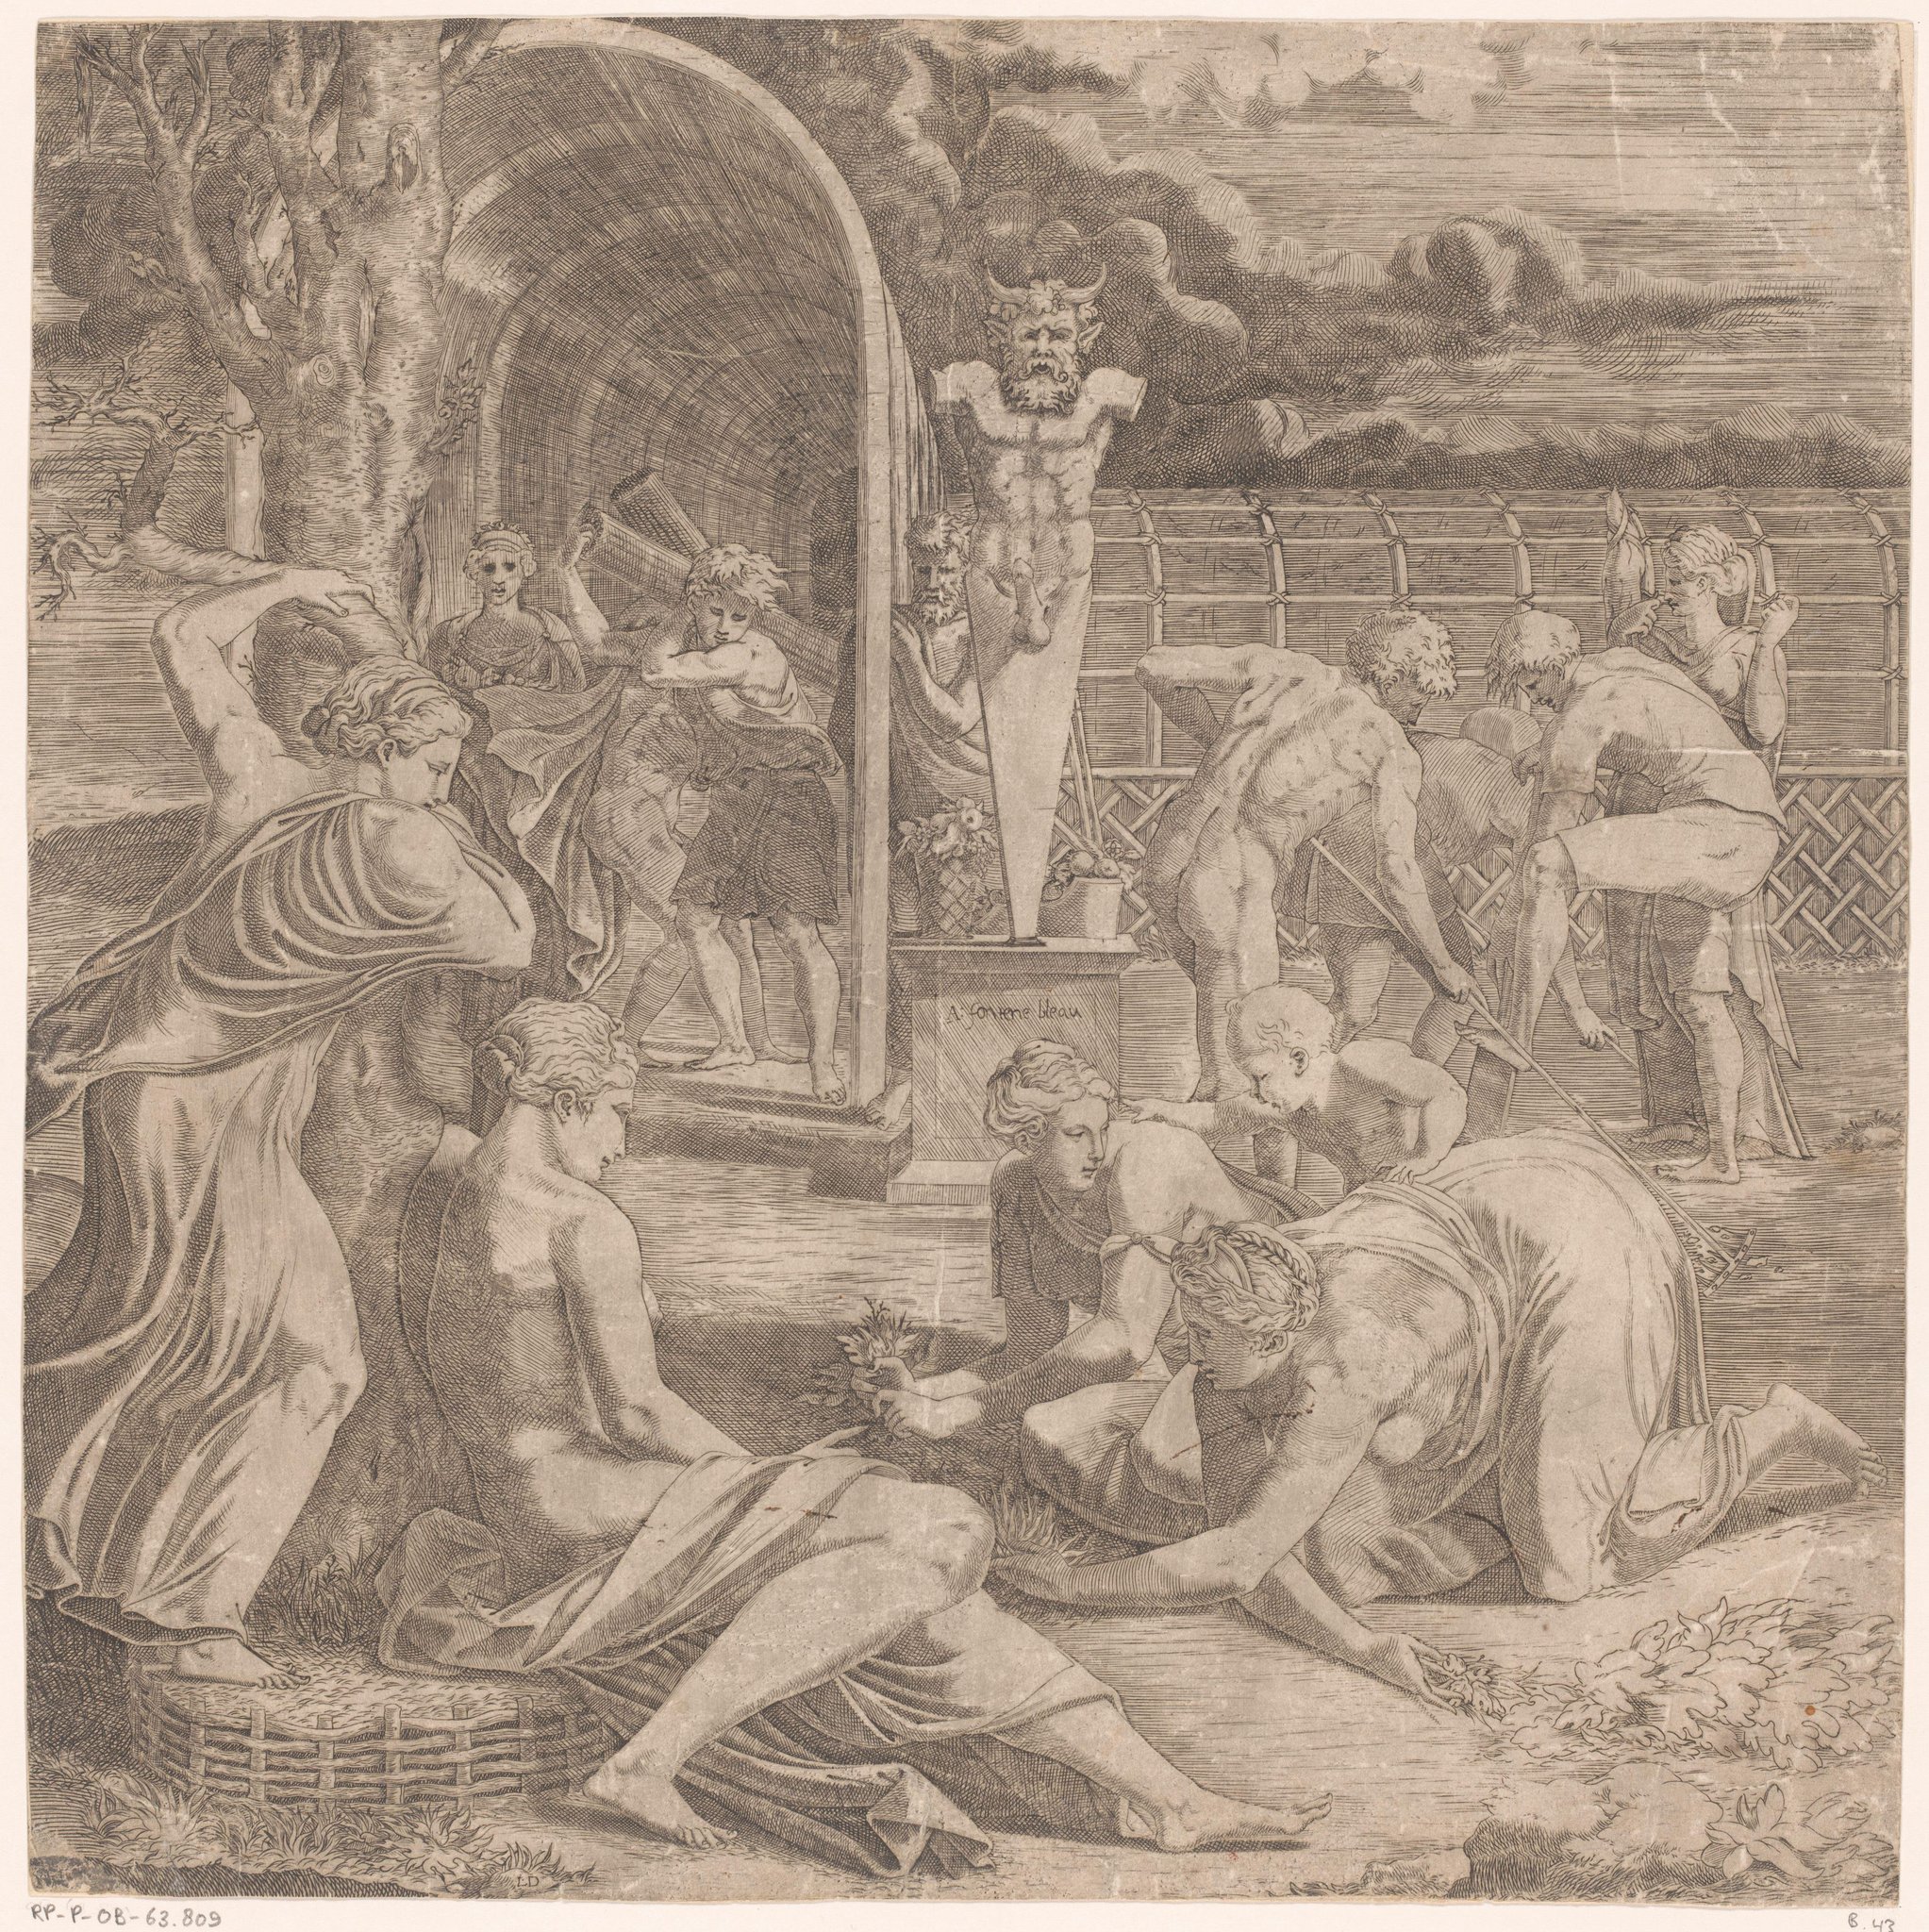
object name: print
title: Figuren verzorgen een tuin met een beeld van Priapus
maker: léon davent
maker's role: print maker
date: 1540-1556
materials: paper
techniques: etching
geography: fontainebleau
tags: priapus-herm, gardening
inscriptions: collector's mark: Lugt 240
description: Naar Primaticcio's schildering in het Pavillon de Pomone te Fontainebleau. De tekening van Primaticcio bevindt zich in het Musée du Louvre.